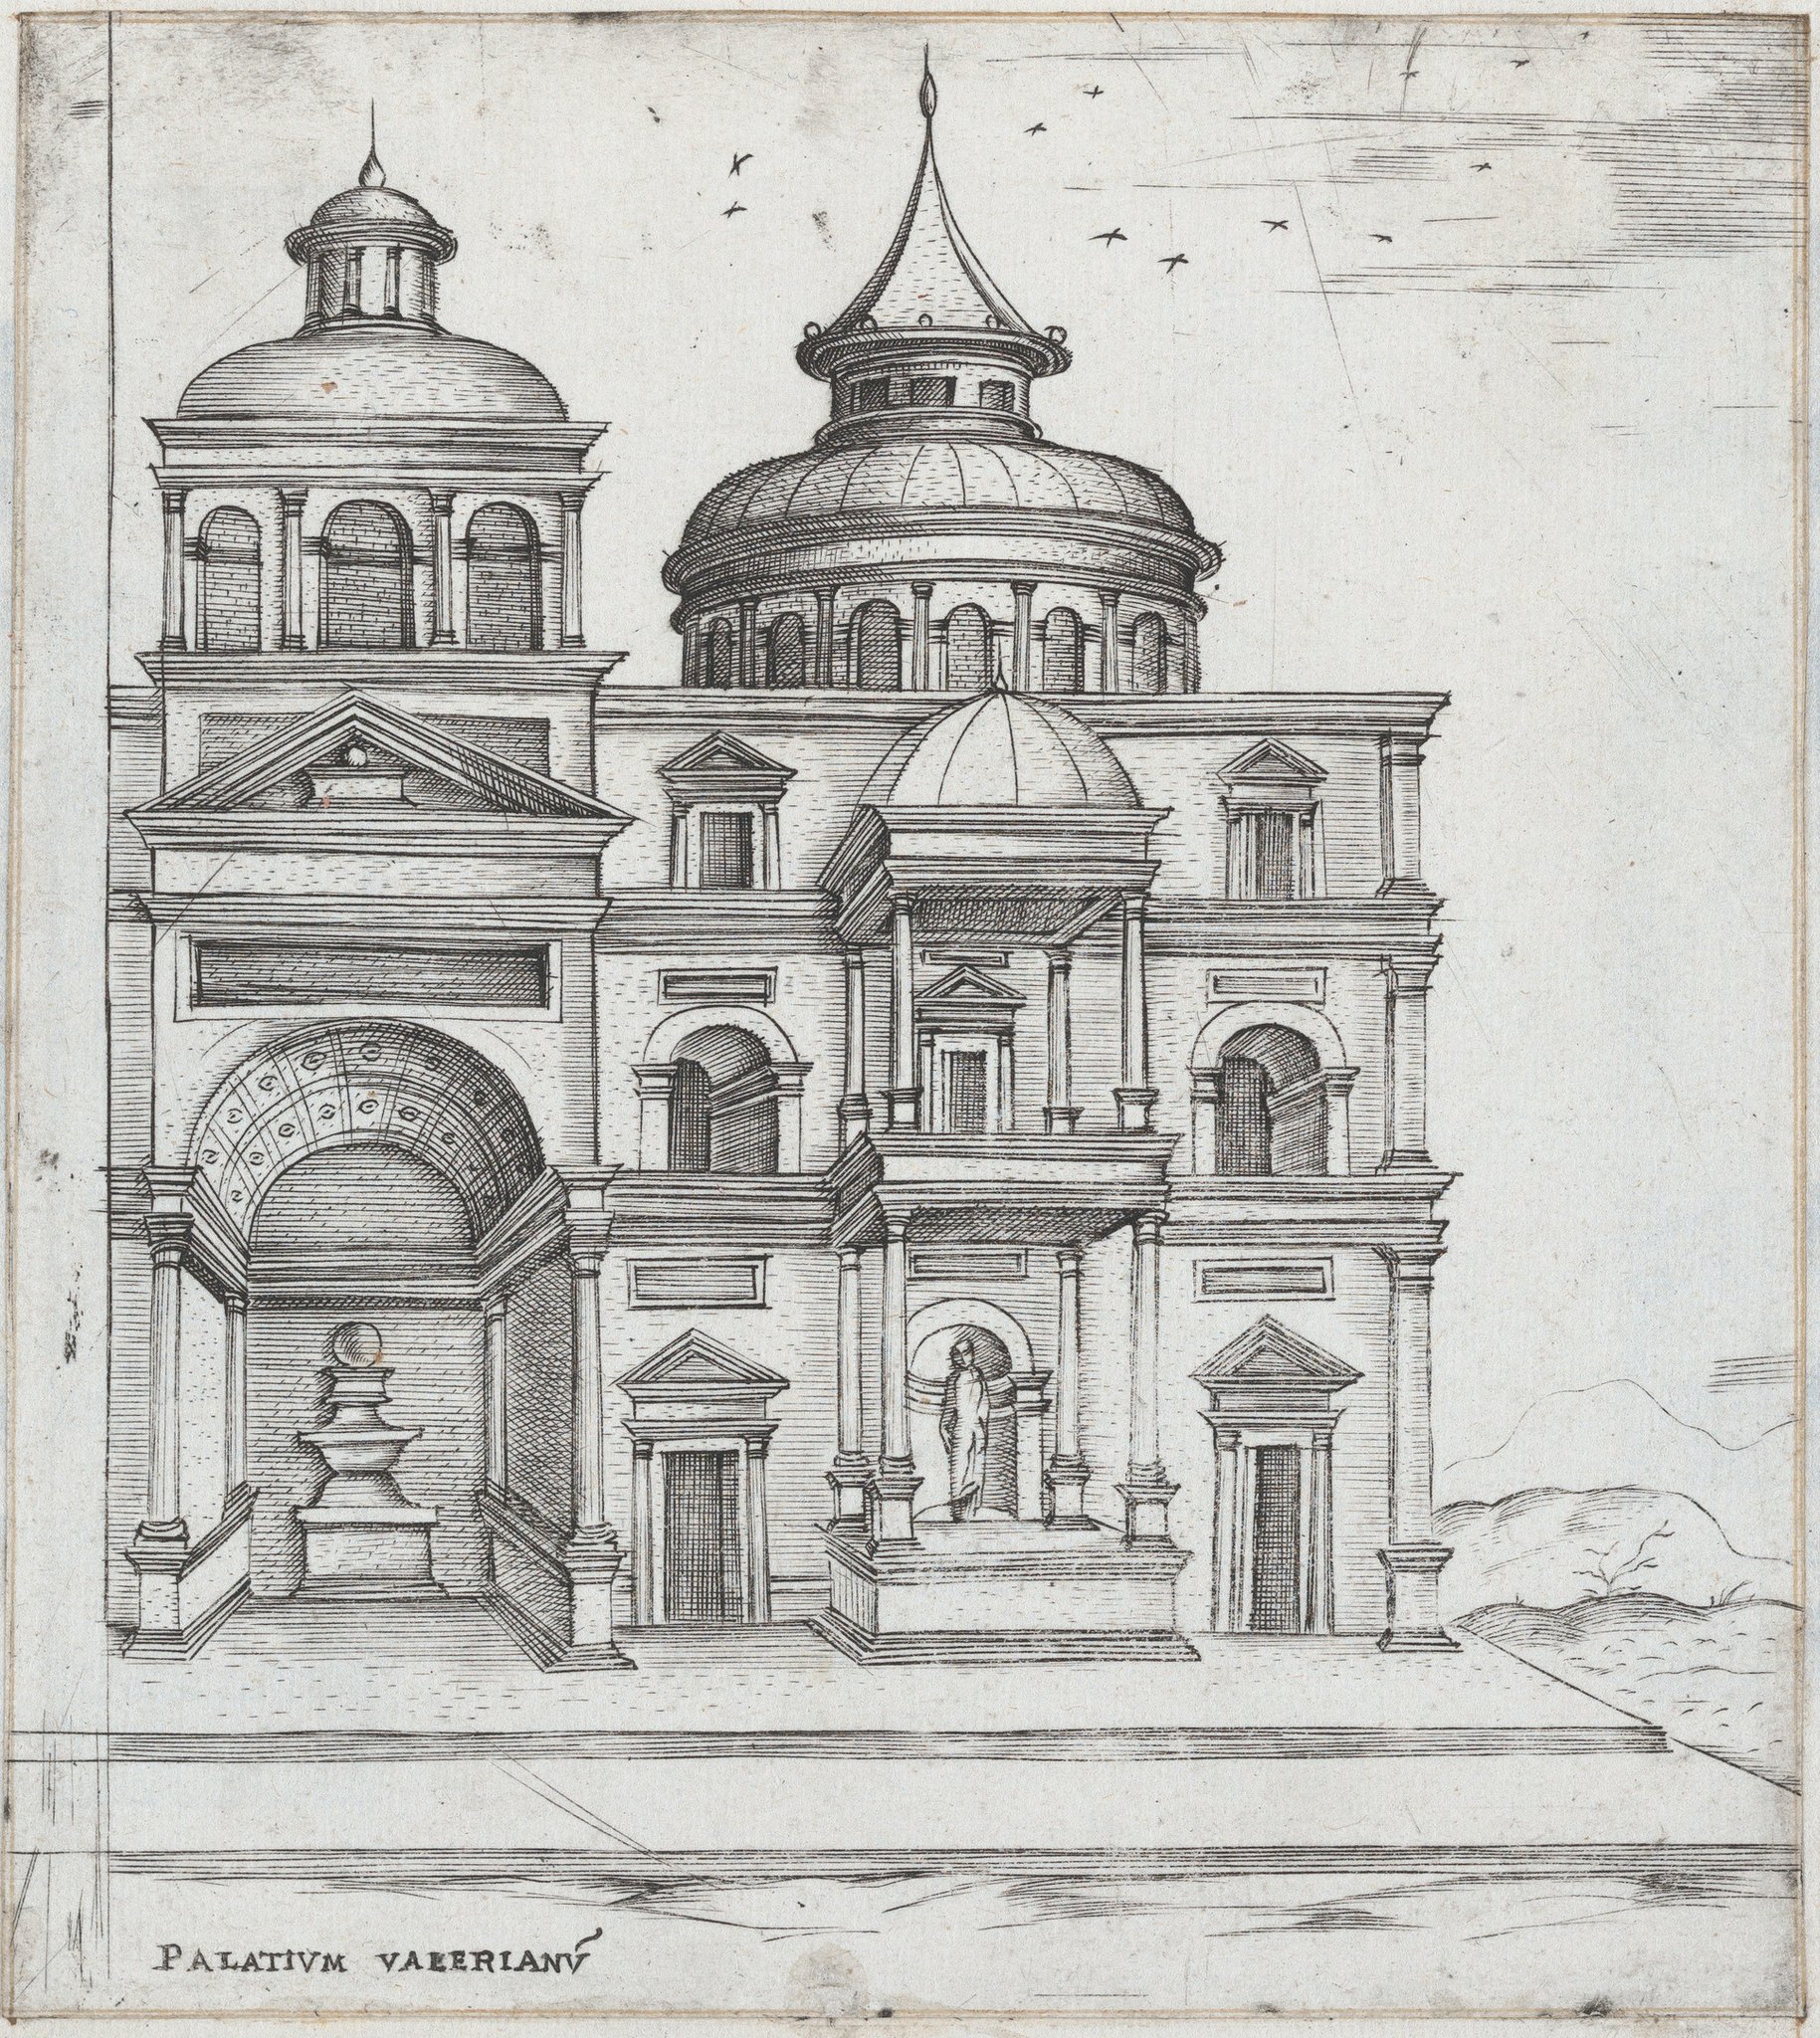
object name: album print ornament architecture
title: Palatium Valerianu[m], from a series of prints depicting (reconstructed) Buildings from Roman Antiquity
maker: monogrammist g.a. with the caltrop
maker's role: artist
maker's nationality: italian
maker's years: 1535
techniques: engraving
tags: buildings